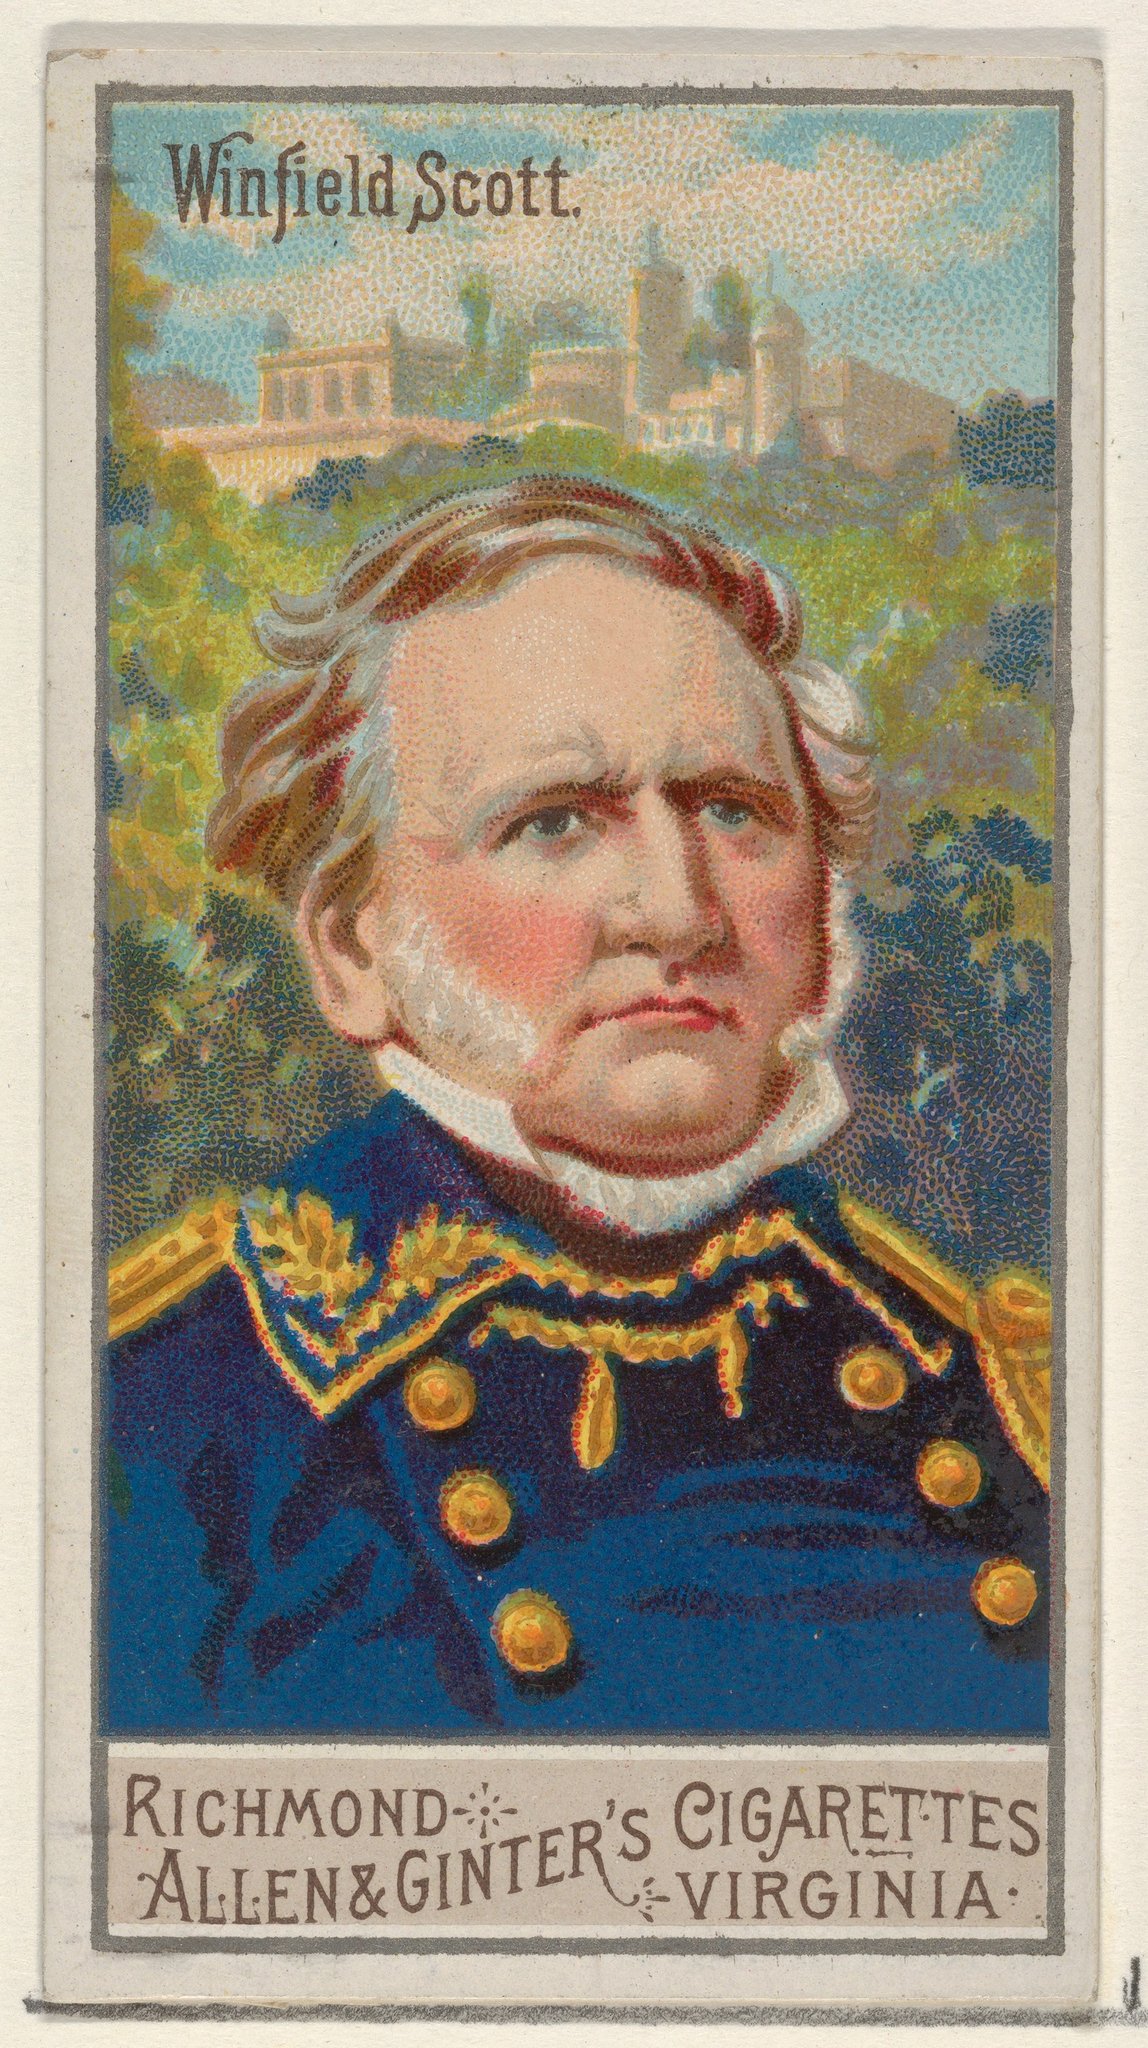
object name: print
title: Winfield Scott, from the Great Generals series (N15) for Allen & Ginter Cigarettes Brands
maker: allen & ginter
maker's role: publisher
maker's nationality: american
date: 1888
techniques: color lithograph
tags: historical figures,men,generals